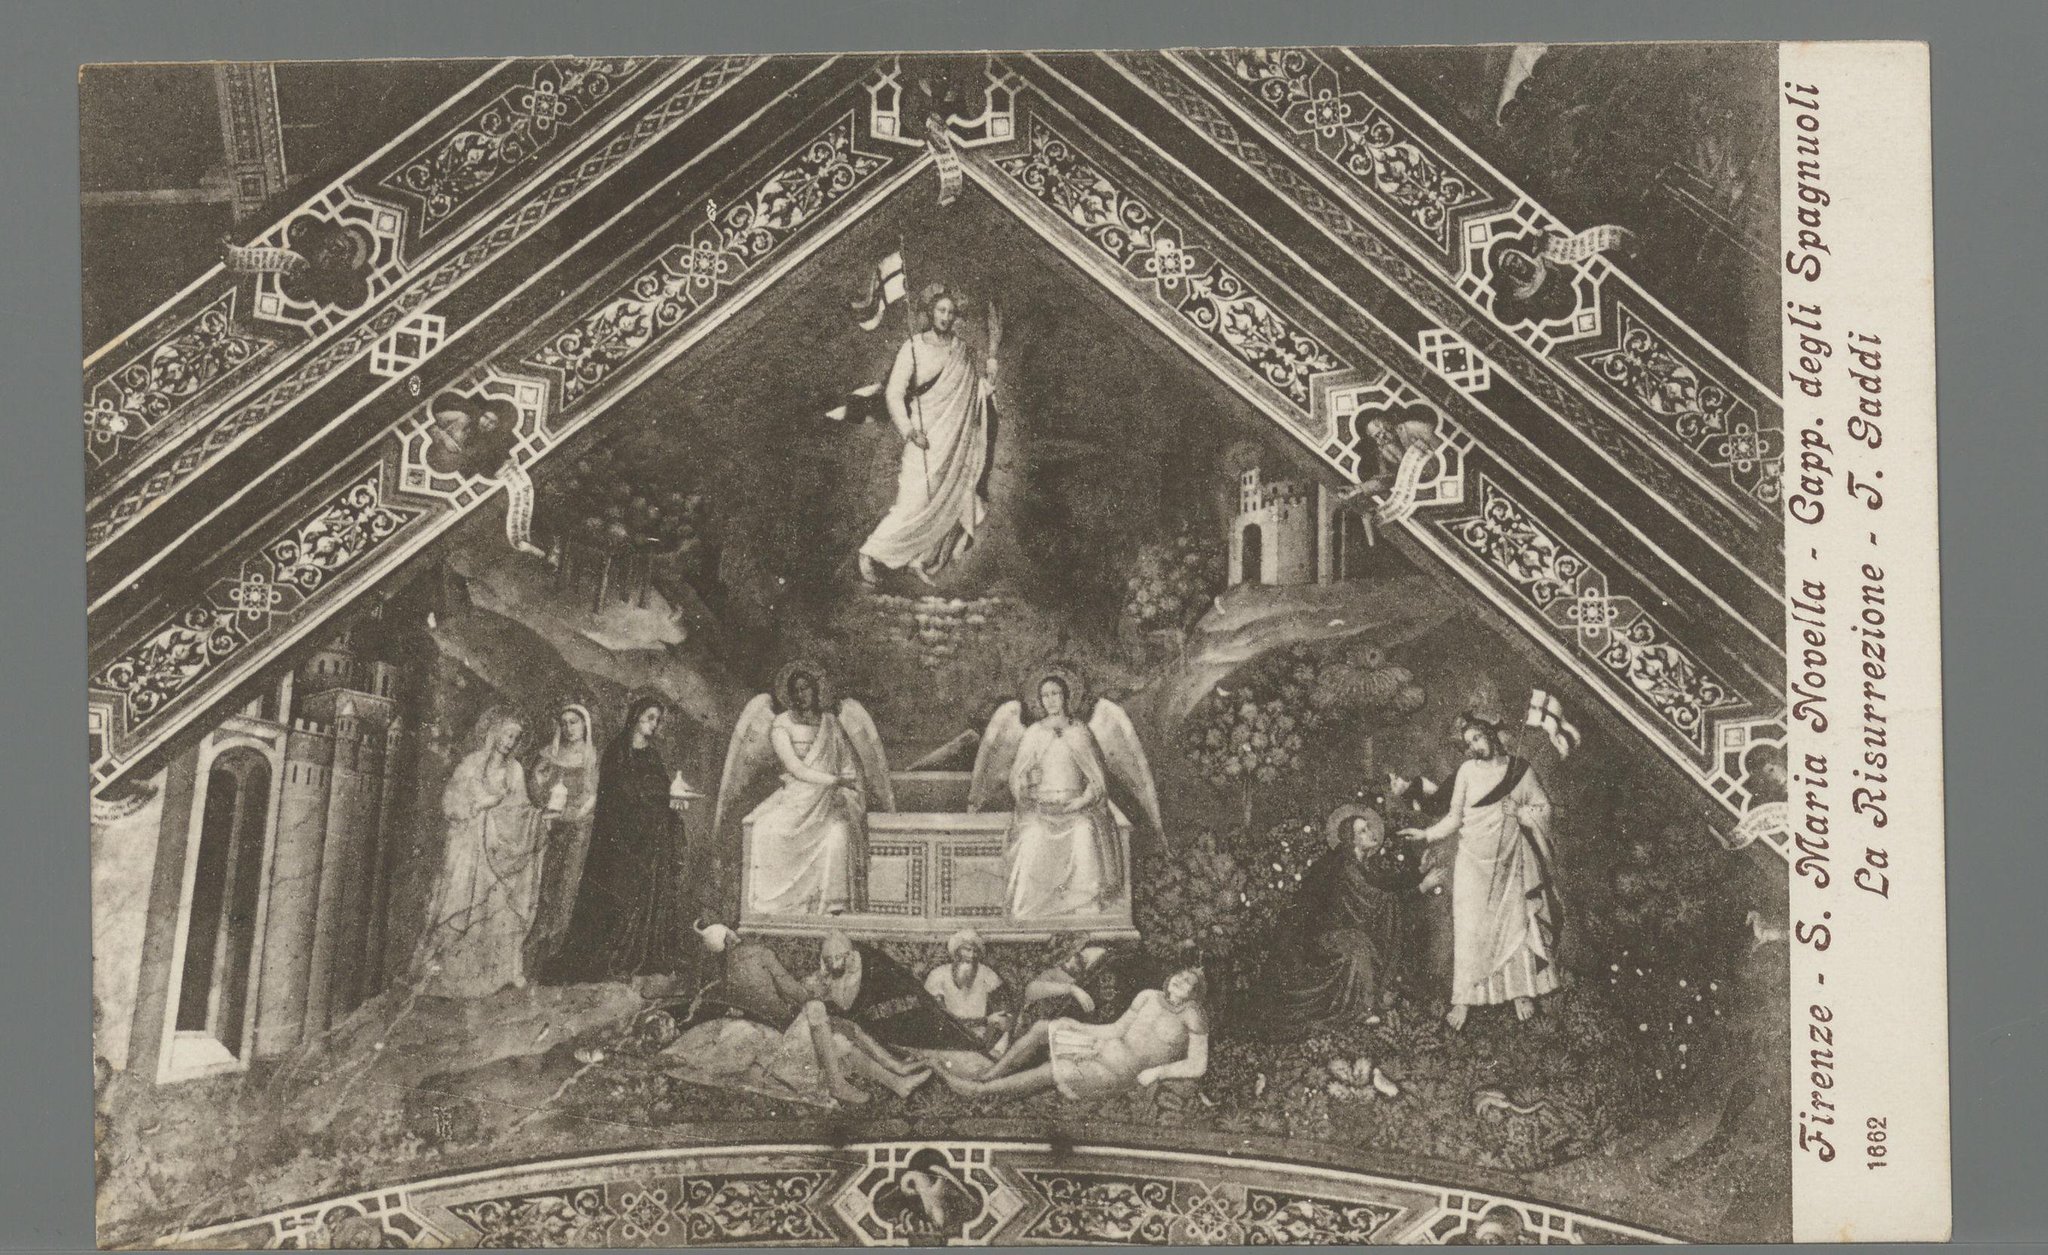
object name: photomechanical print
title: Firenze - S. Maria Novella - Capp. degli Spagnuoli. La Risurrezione - T. Gaddi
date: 1906-1930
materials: cardboard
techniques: photograph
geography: florence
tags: church (exterior), picture, painting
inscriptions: monogram, collector's mark: ‘AFE v S’